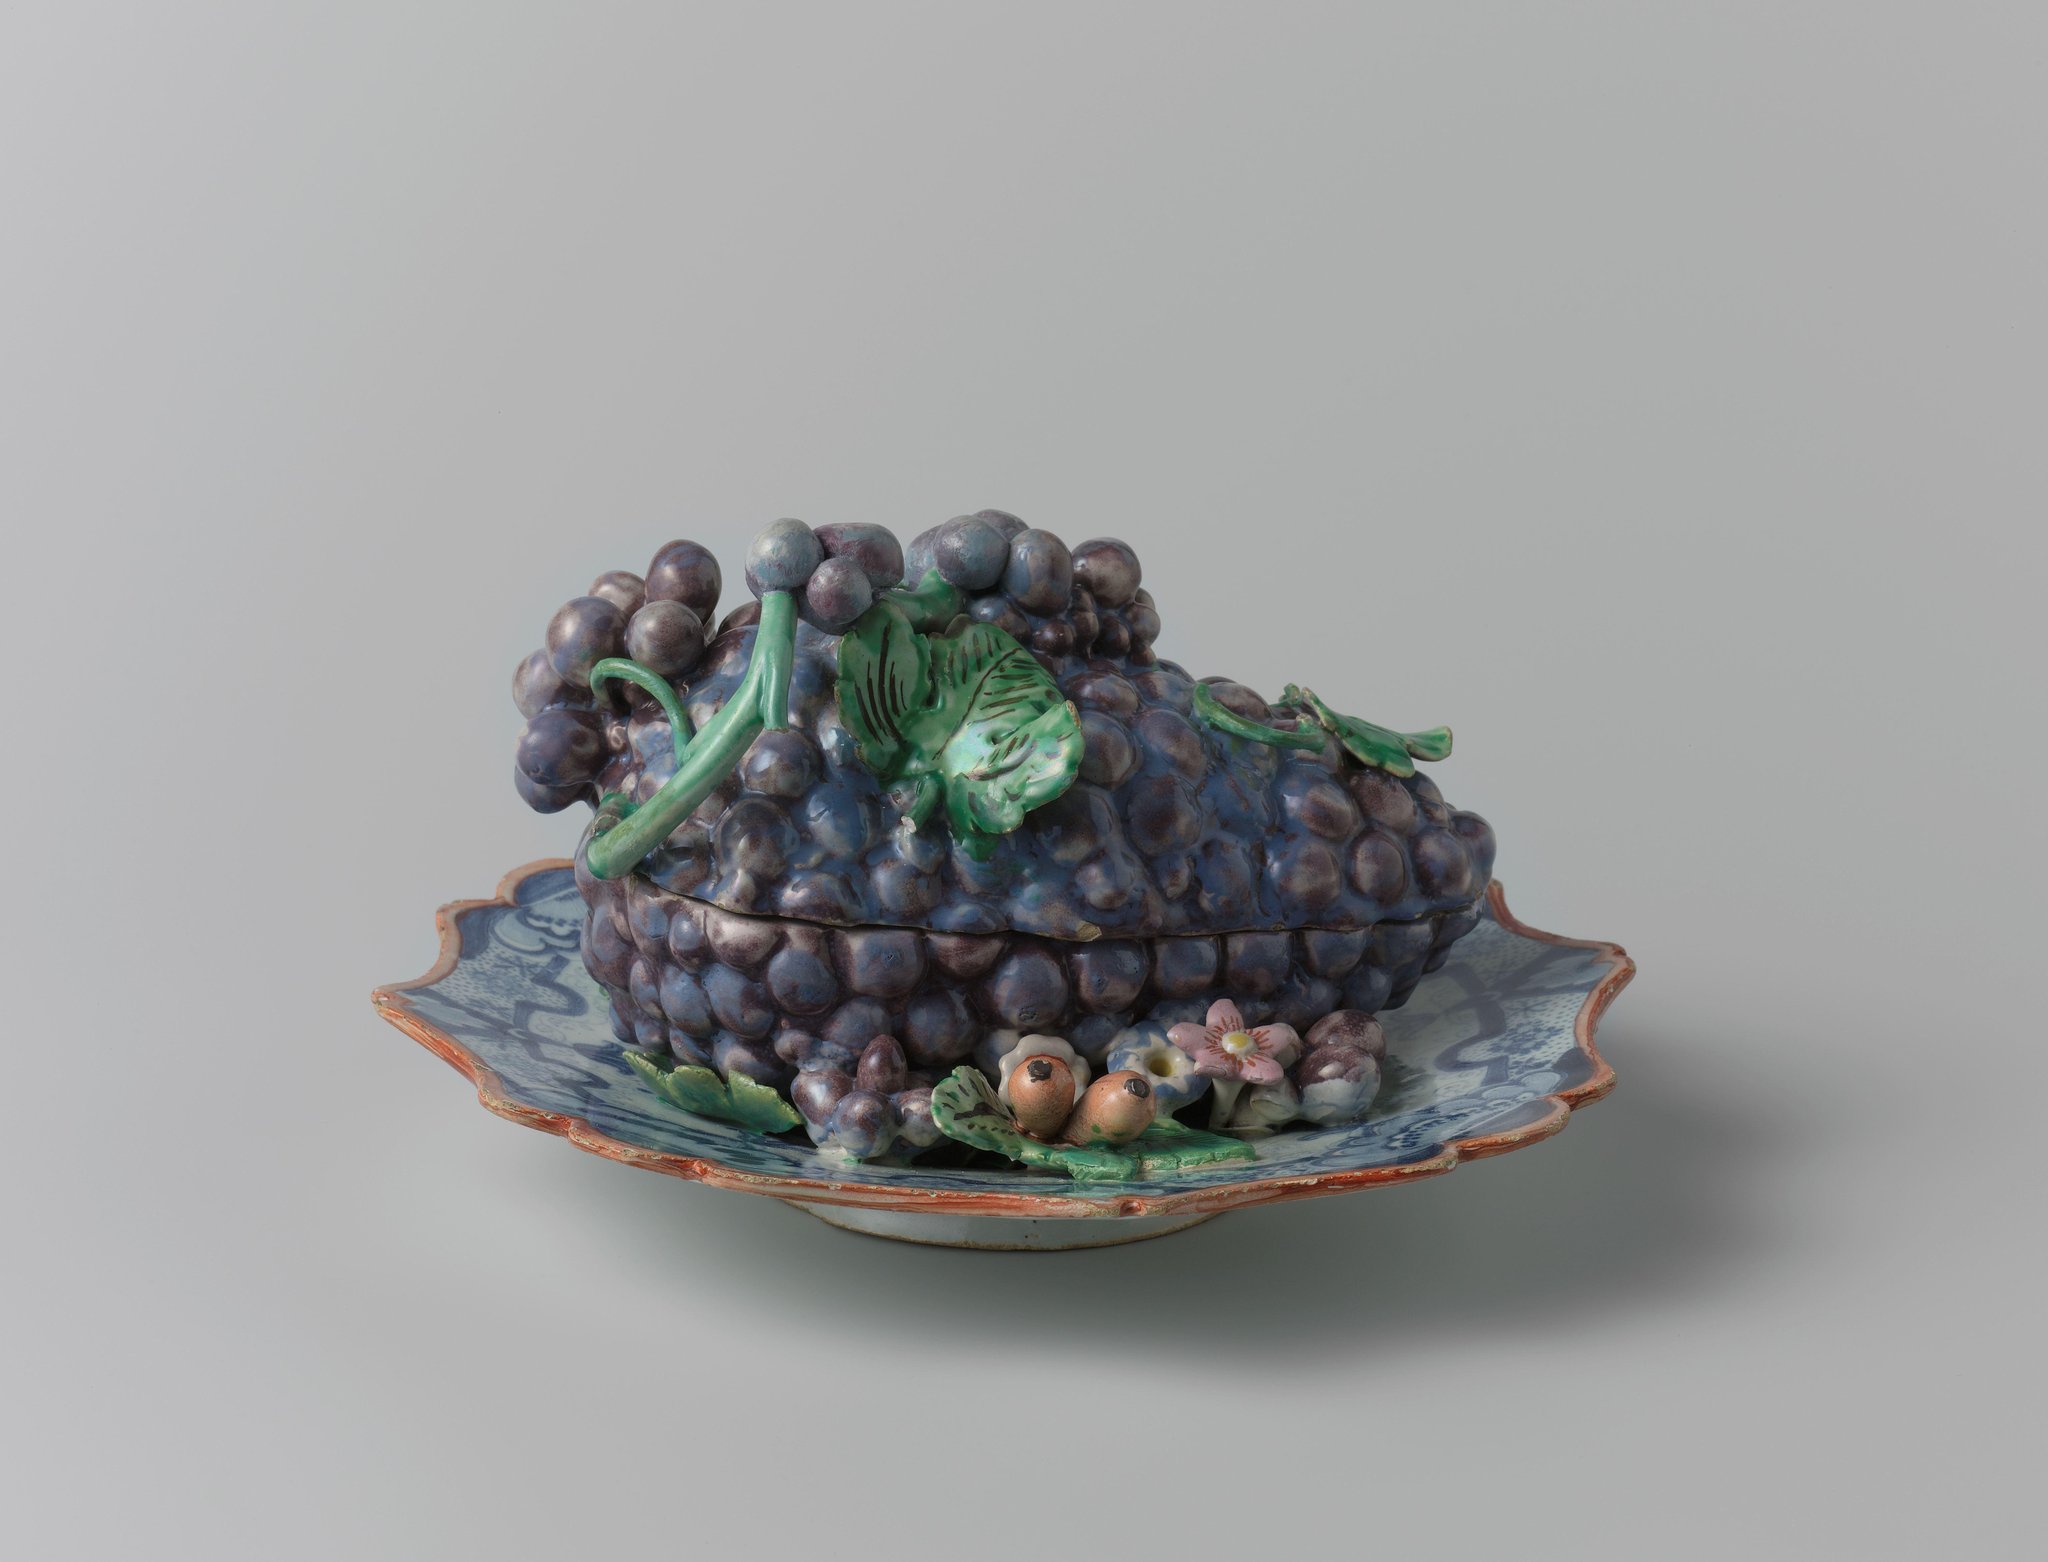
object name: tureen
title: Deksel van terrine in de vorm van een druiventros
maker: arie blankers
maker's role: plateelbakker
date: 1756-1764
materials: earthenware, glaze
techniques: painted, polychromy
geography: amsterdam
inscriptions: mark: ‘AB(ineen)/ AD(ineen)’, mark: ‘AB(ineen)/ D’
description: Deksel van veelkleurig beschilderde faience.